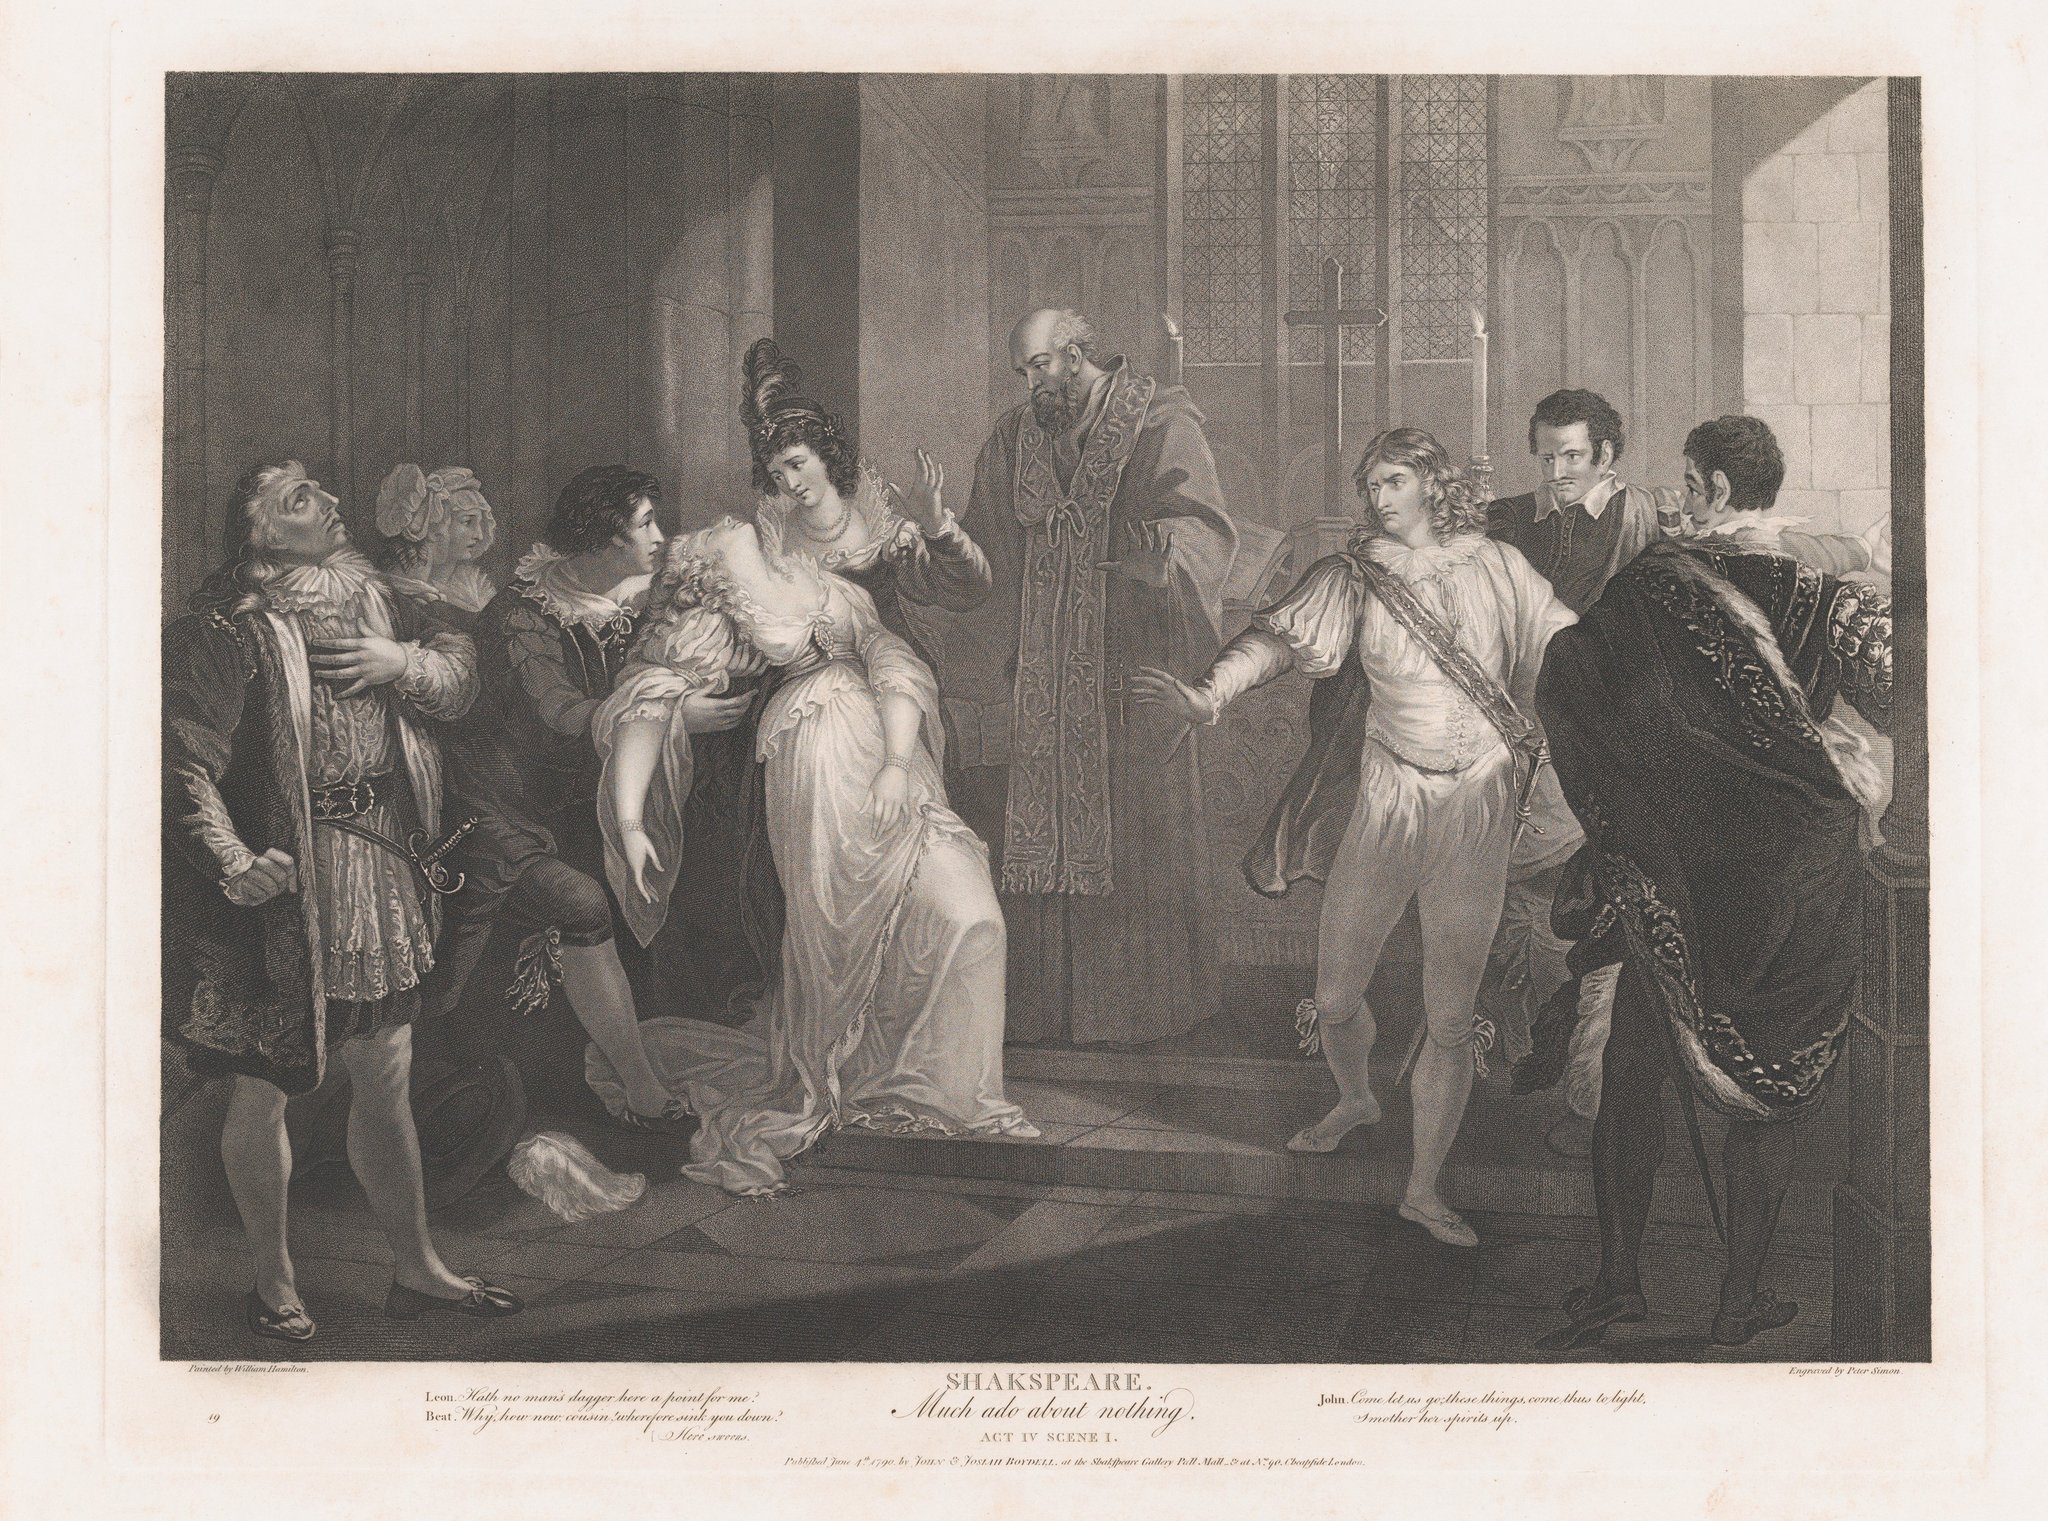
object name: print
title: Hero Fainting in Church (Shakespeare, Much Ado About Nothing, Act 4, Scene 1)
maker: peter simon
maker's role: engraver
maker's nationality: british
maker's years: 1764-1813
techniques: engraving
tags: shakespeare,men,women